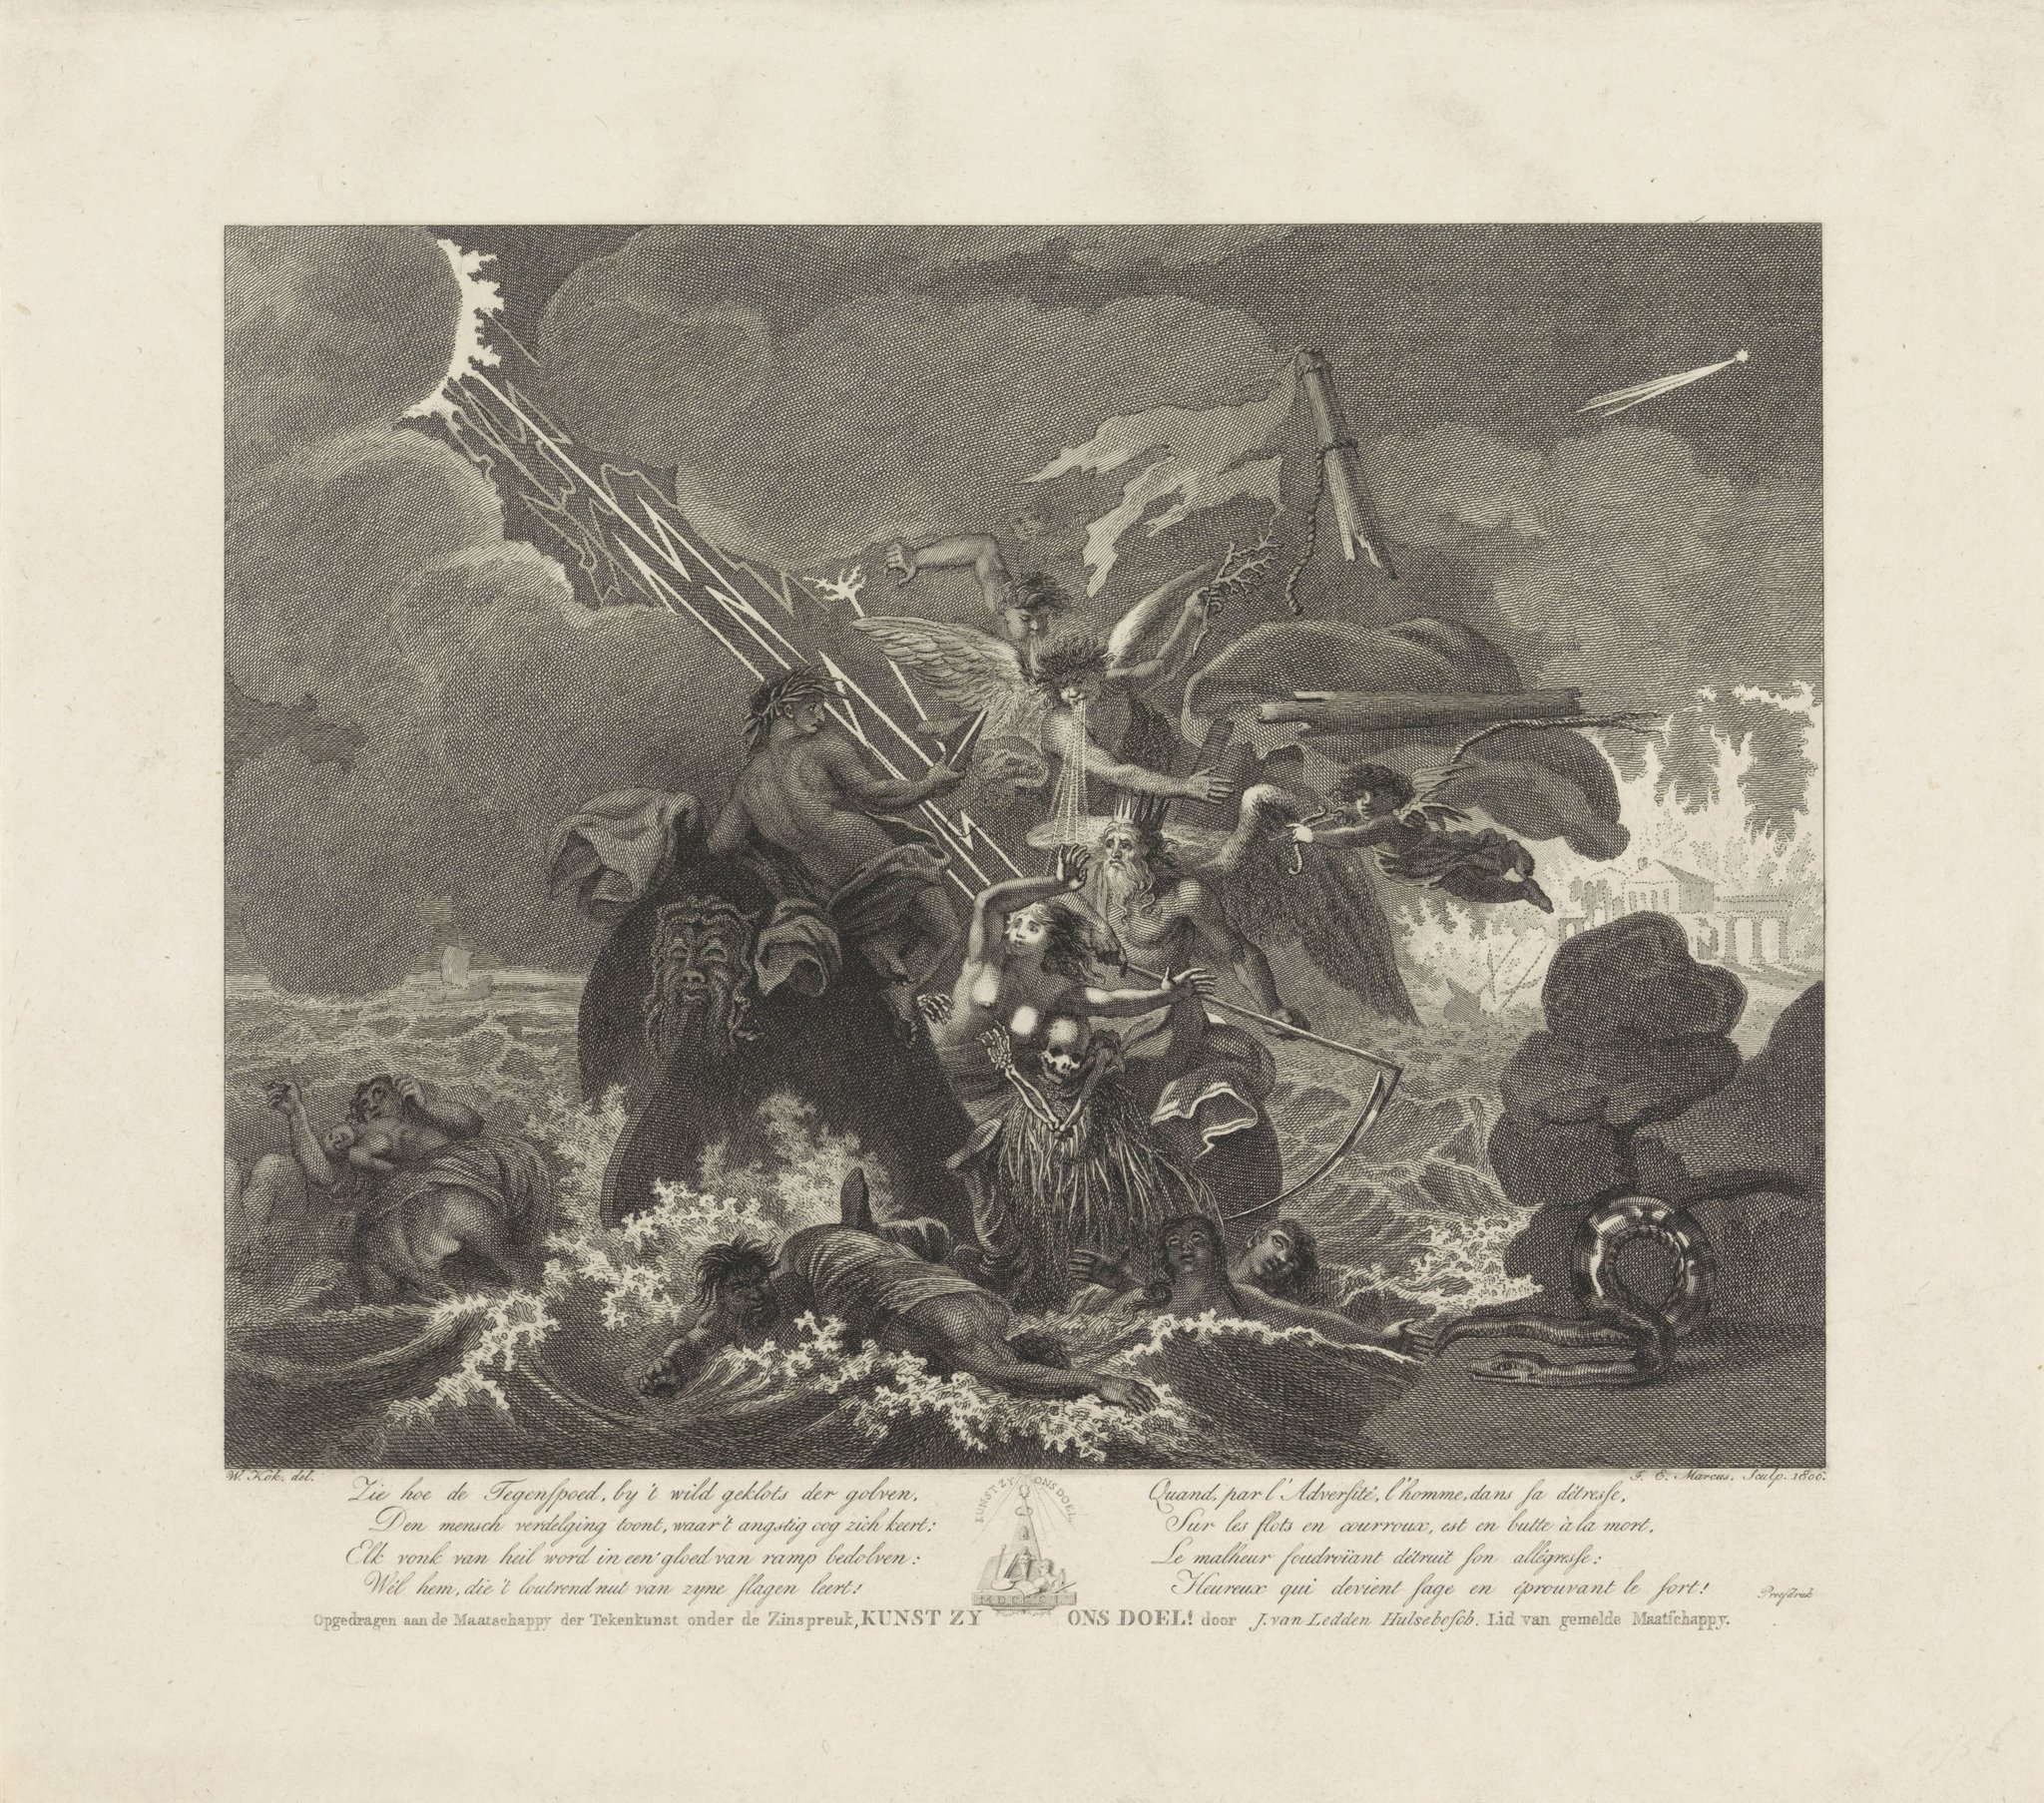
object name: print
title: Allegorie op de tegenspoed, 1806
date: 1806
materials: paper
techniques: engraving, etching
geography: netherlands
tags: adversity, misfortune, bad luck; 'fortuna infelice', 'infortunio' (ripa)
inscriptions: collector's mark: Lugt 2228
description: Allegorische voorstelling met een scheepje waarin een naakte vrouw zit tijdens een zware storm, de Dood heeft zijn arm om haar heen geslagen. Uit de hemel schieten bliksemschichten, in de golven drenkelingen. Op de kust een slang en een brandende stad. Allegorie op de mens en maatschappij, 1806. In het onderschrift twee vierregelige verzen in het Nederlands en Frans, aan weerszijden van het vignet 'Kunst zy ons Doel'. Zie ook de pendant met de Voorspoed.